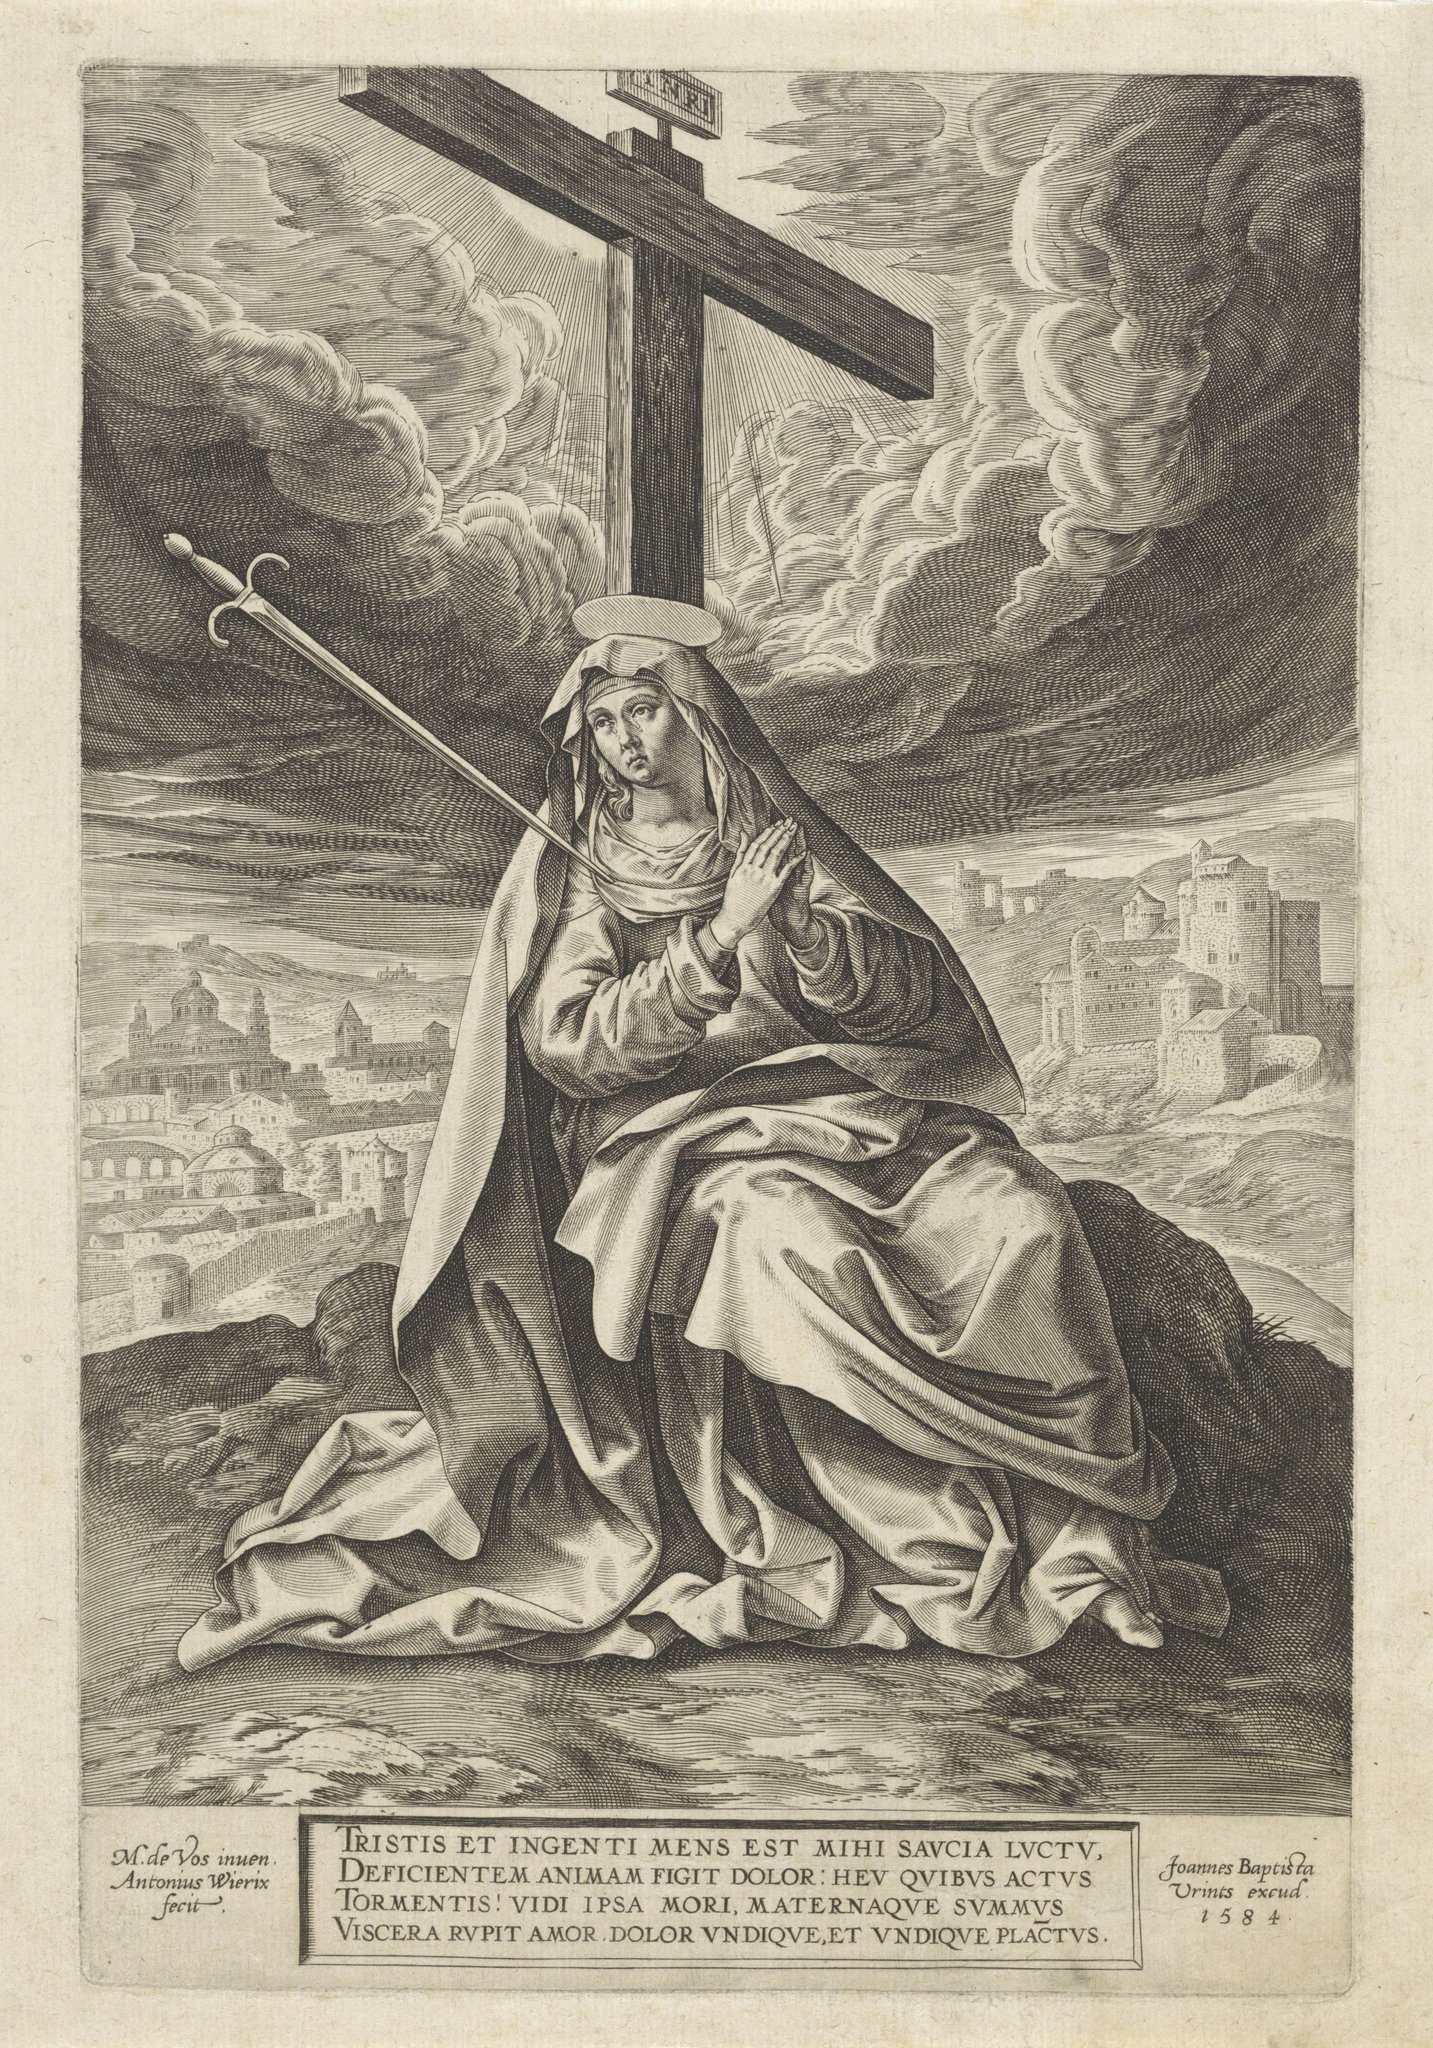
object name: print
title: Maria als Mater Dolorosa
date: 1584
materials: paper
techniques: engraving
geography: antwerp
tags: mary pierced by a sword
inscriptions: collector's mark: Lugt 2228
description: Maria zit met een zwaard in haar borst aan de voet van het lege kruis. Stralen schijnen op haar vanuit de hemel. Op de achtergrond een gezicht op Jeruzalem. In het kader onder de voorstelling een vierregelig onderschrift in het Latijn.